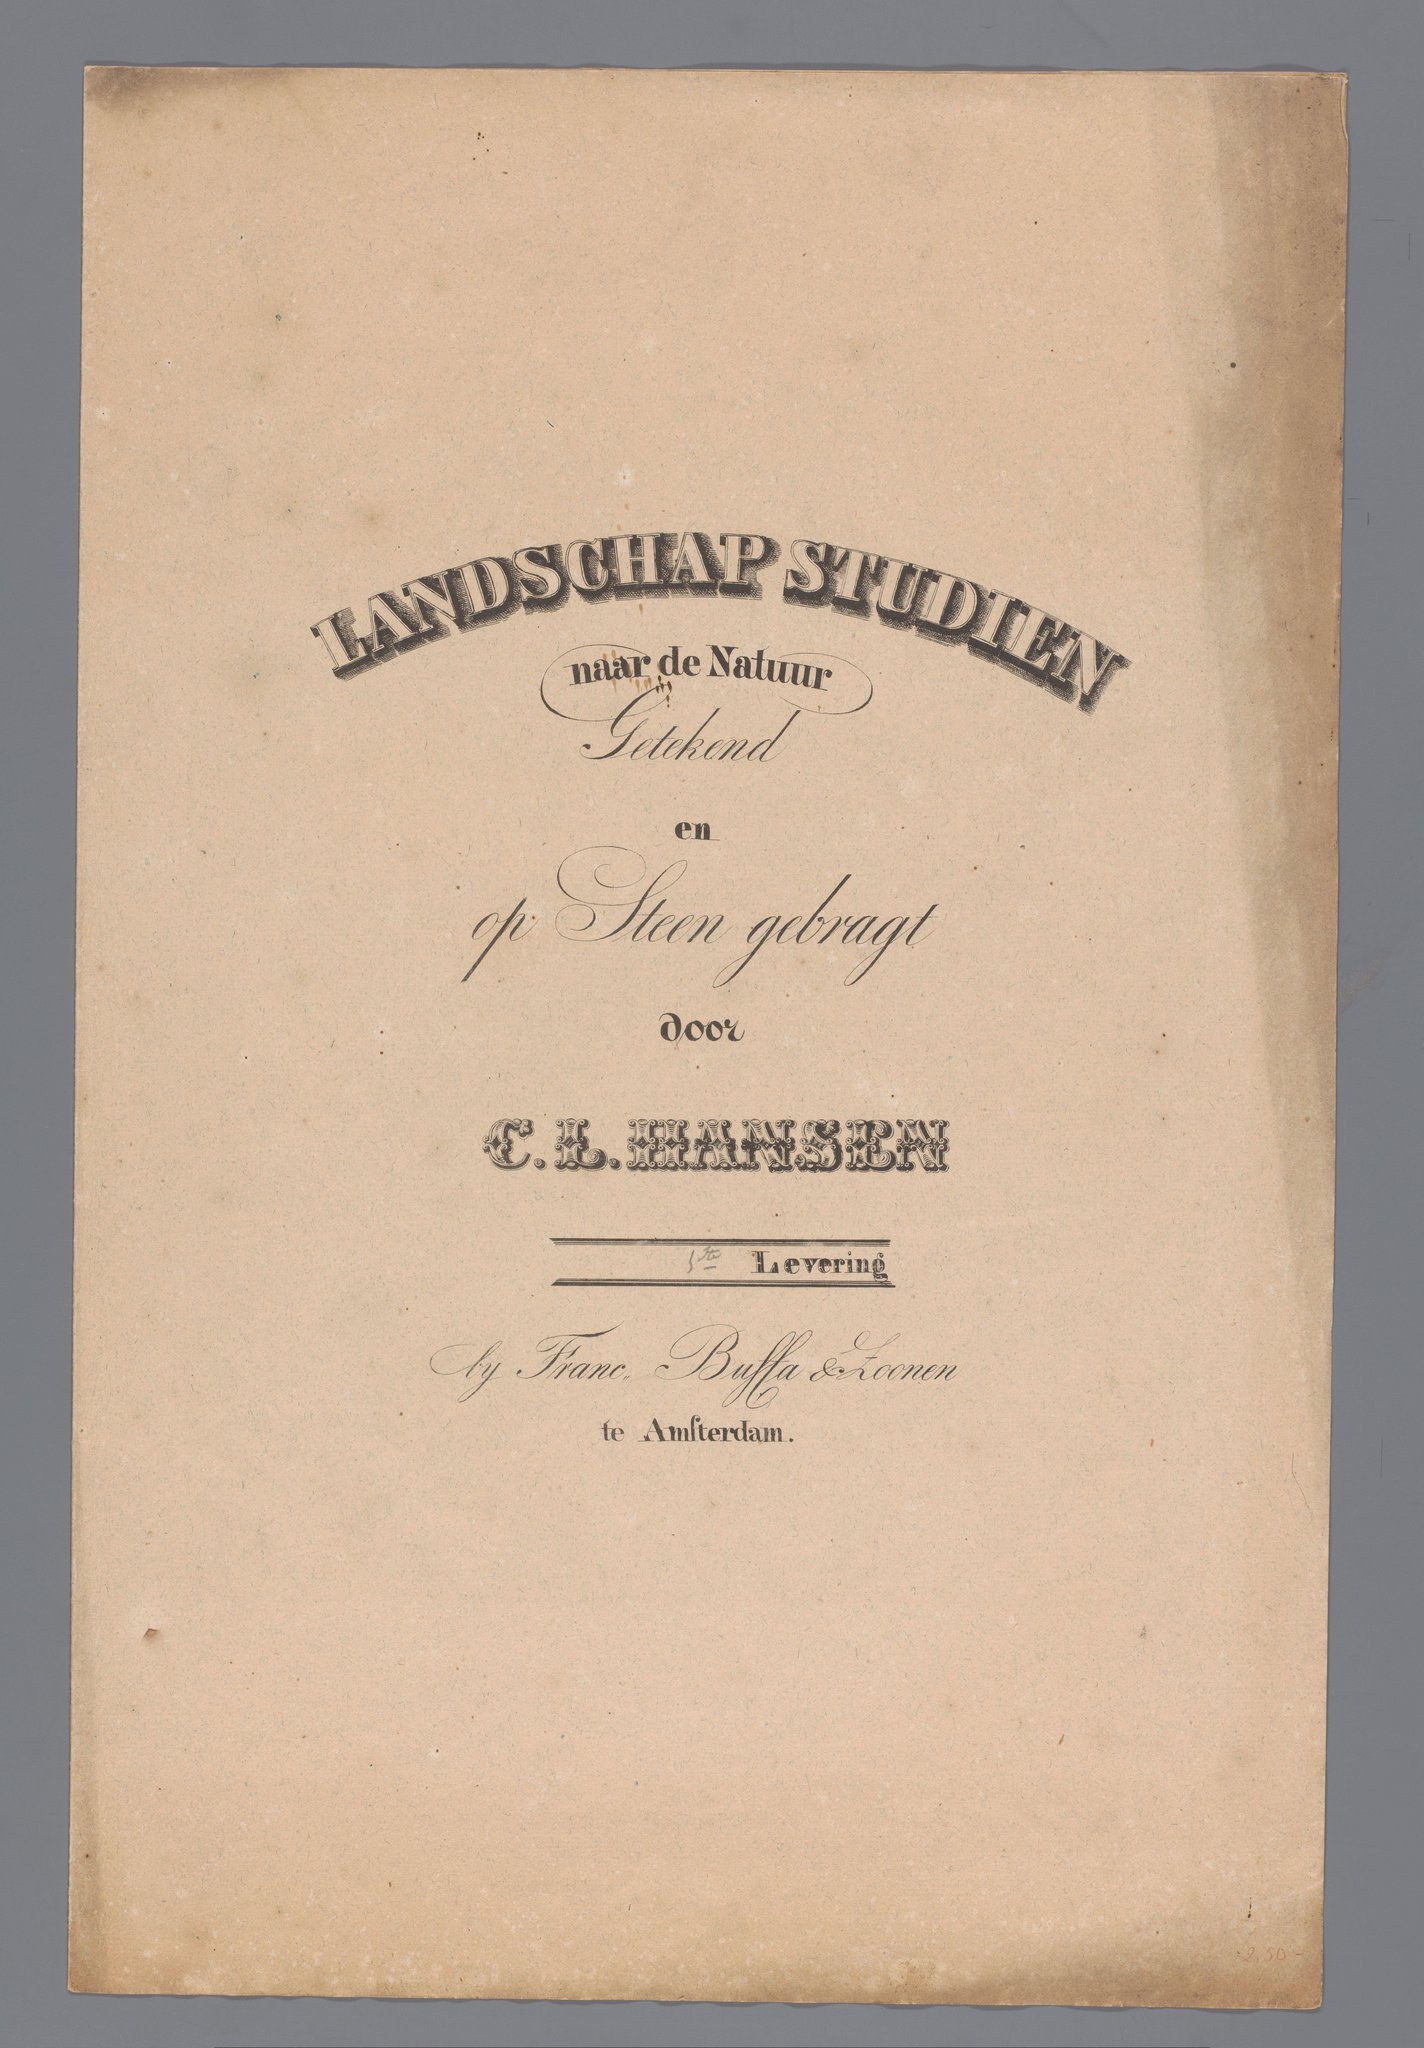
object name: print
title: Landschap Studien naar de Natuur getekend en op steen gebracht door C.L. Hansen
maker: carel lodewijk hansen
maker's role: draughtsman, painter, print maker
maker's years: 1765-1840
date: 1809-1840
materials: paper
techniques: lithograph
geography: netherlands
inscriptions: inscription: ‘1ste’, inscription: ‘F 2,50-’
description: In deze omslag bevinden zich zes prenten, genummerd 1 tot en met 6.